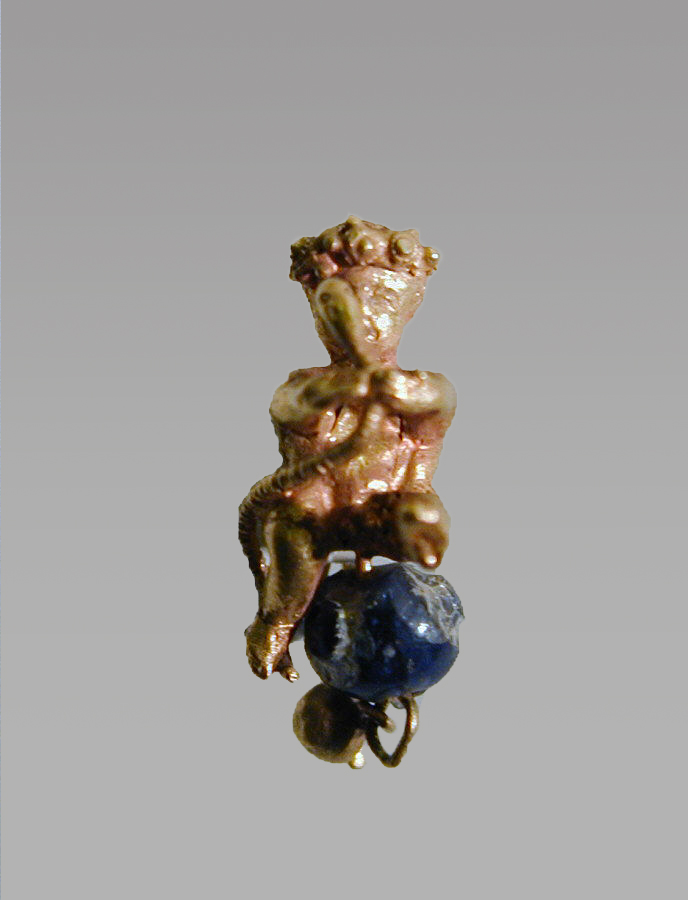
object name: earring in the form of the infant herakles with a snake, pair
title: Pair of gold and glass earrings with baby Herakles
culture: greek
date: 200-1 BCE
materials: glass, gold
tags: infants,snakes,herakles